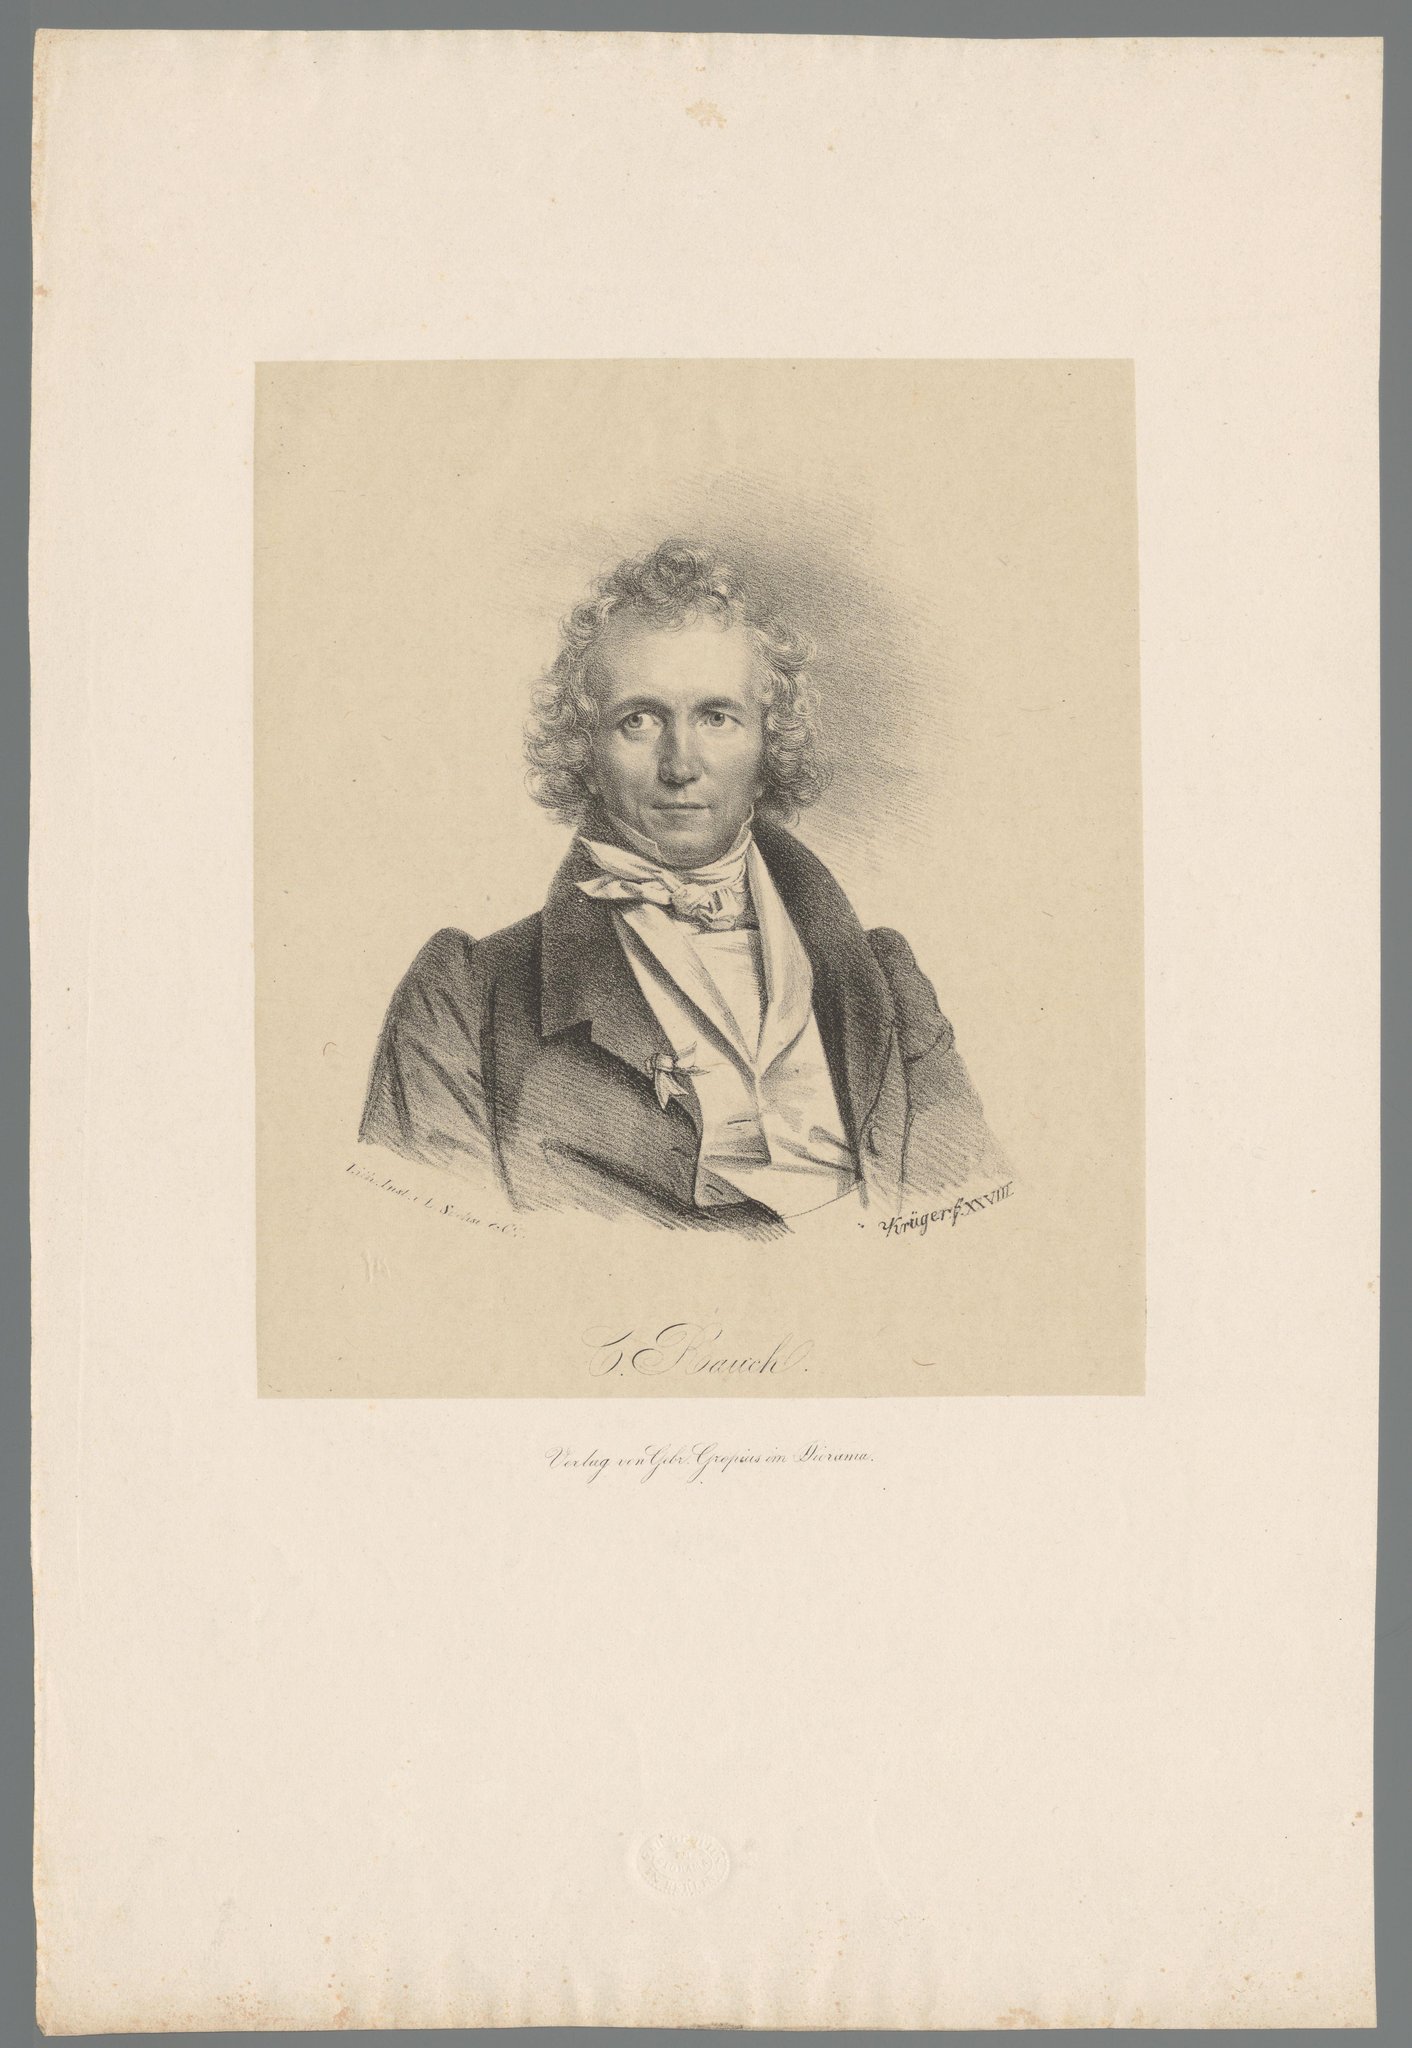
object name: print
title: C. Rauch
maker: franz krüger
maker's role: draughtsman, print maker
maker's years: 1797-1857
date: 1807-1857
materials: paper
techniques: lithograph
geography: berlin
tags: sculptor, christian daniel rauch, portrait, self-portrait of sculptor, historical persons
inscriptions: check stamp: Lugt 5415, collector's mark: Lugt 2228